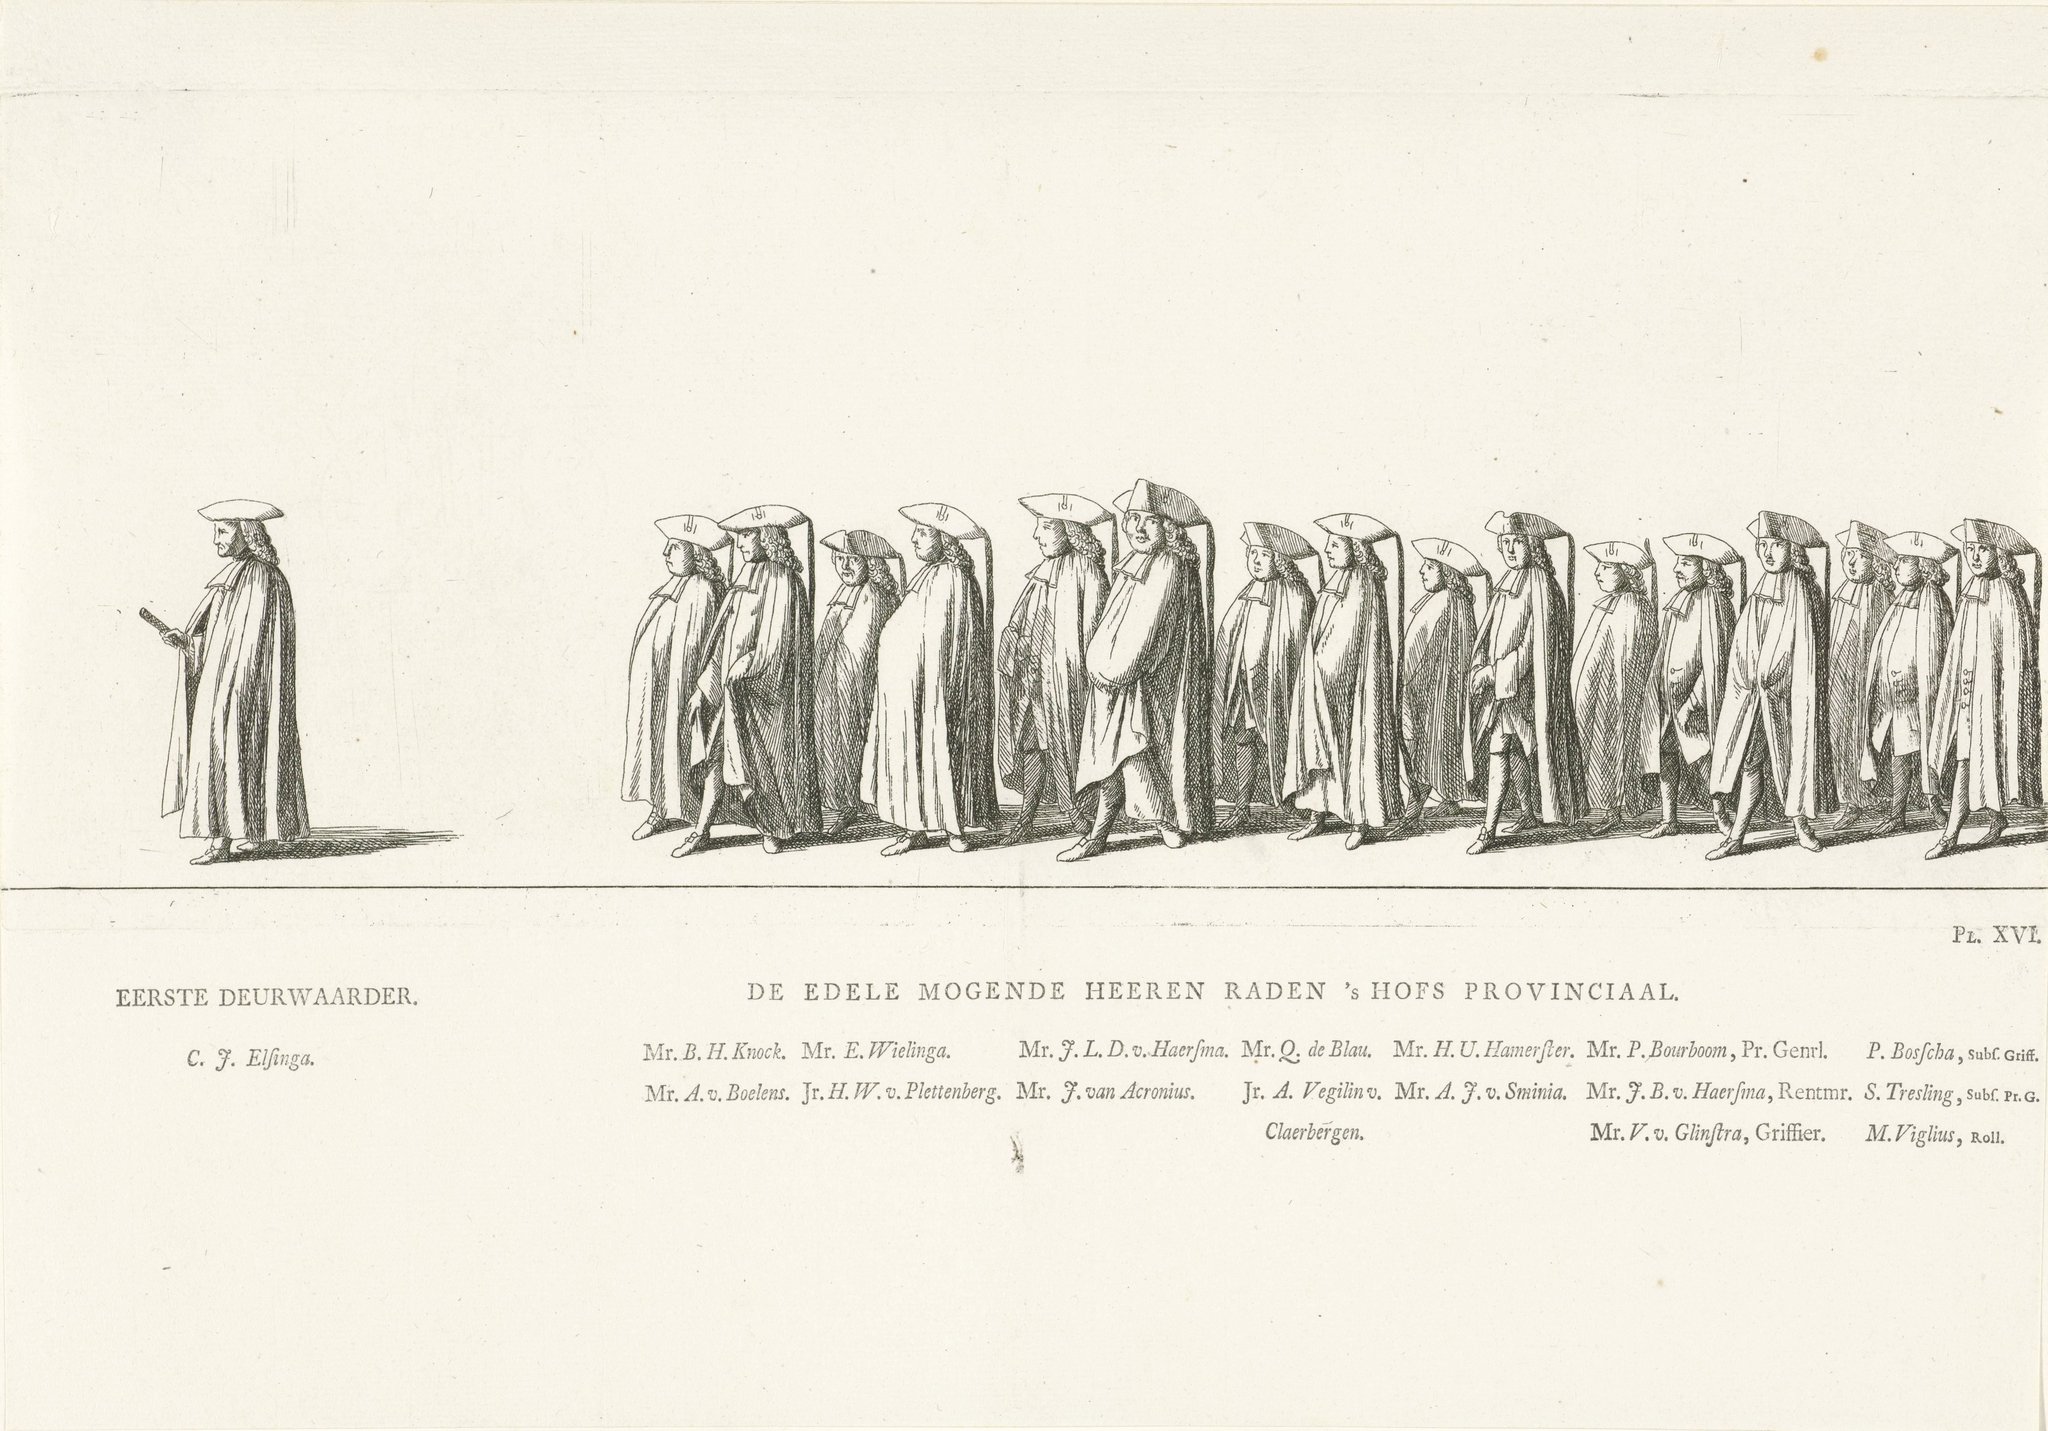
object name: print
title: Leden van het Hof van Friesland in de begrafenisstoet van prinses Maria Louise, 1765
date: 1765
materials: paper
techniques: etching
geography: leeuwarden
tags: cortege, funeral procession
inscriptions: collector's mark: Lugt 2228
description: Leden van het Hof van Friesland. Gemerkt rechtsonder: Pl. XVI. Op het blad onder de plaat de namen van personen in de stoet. Onderdeel van de serie platen van de begrafenis van prinses Maria Louise te Leeuwarden op 13 juni 1765.